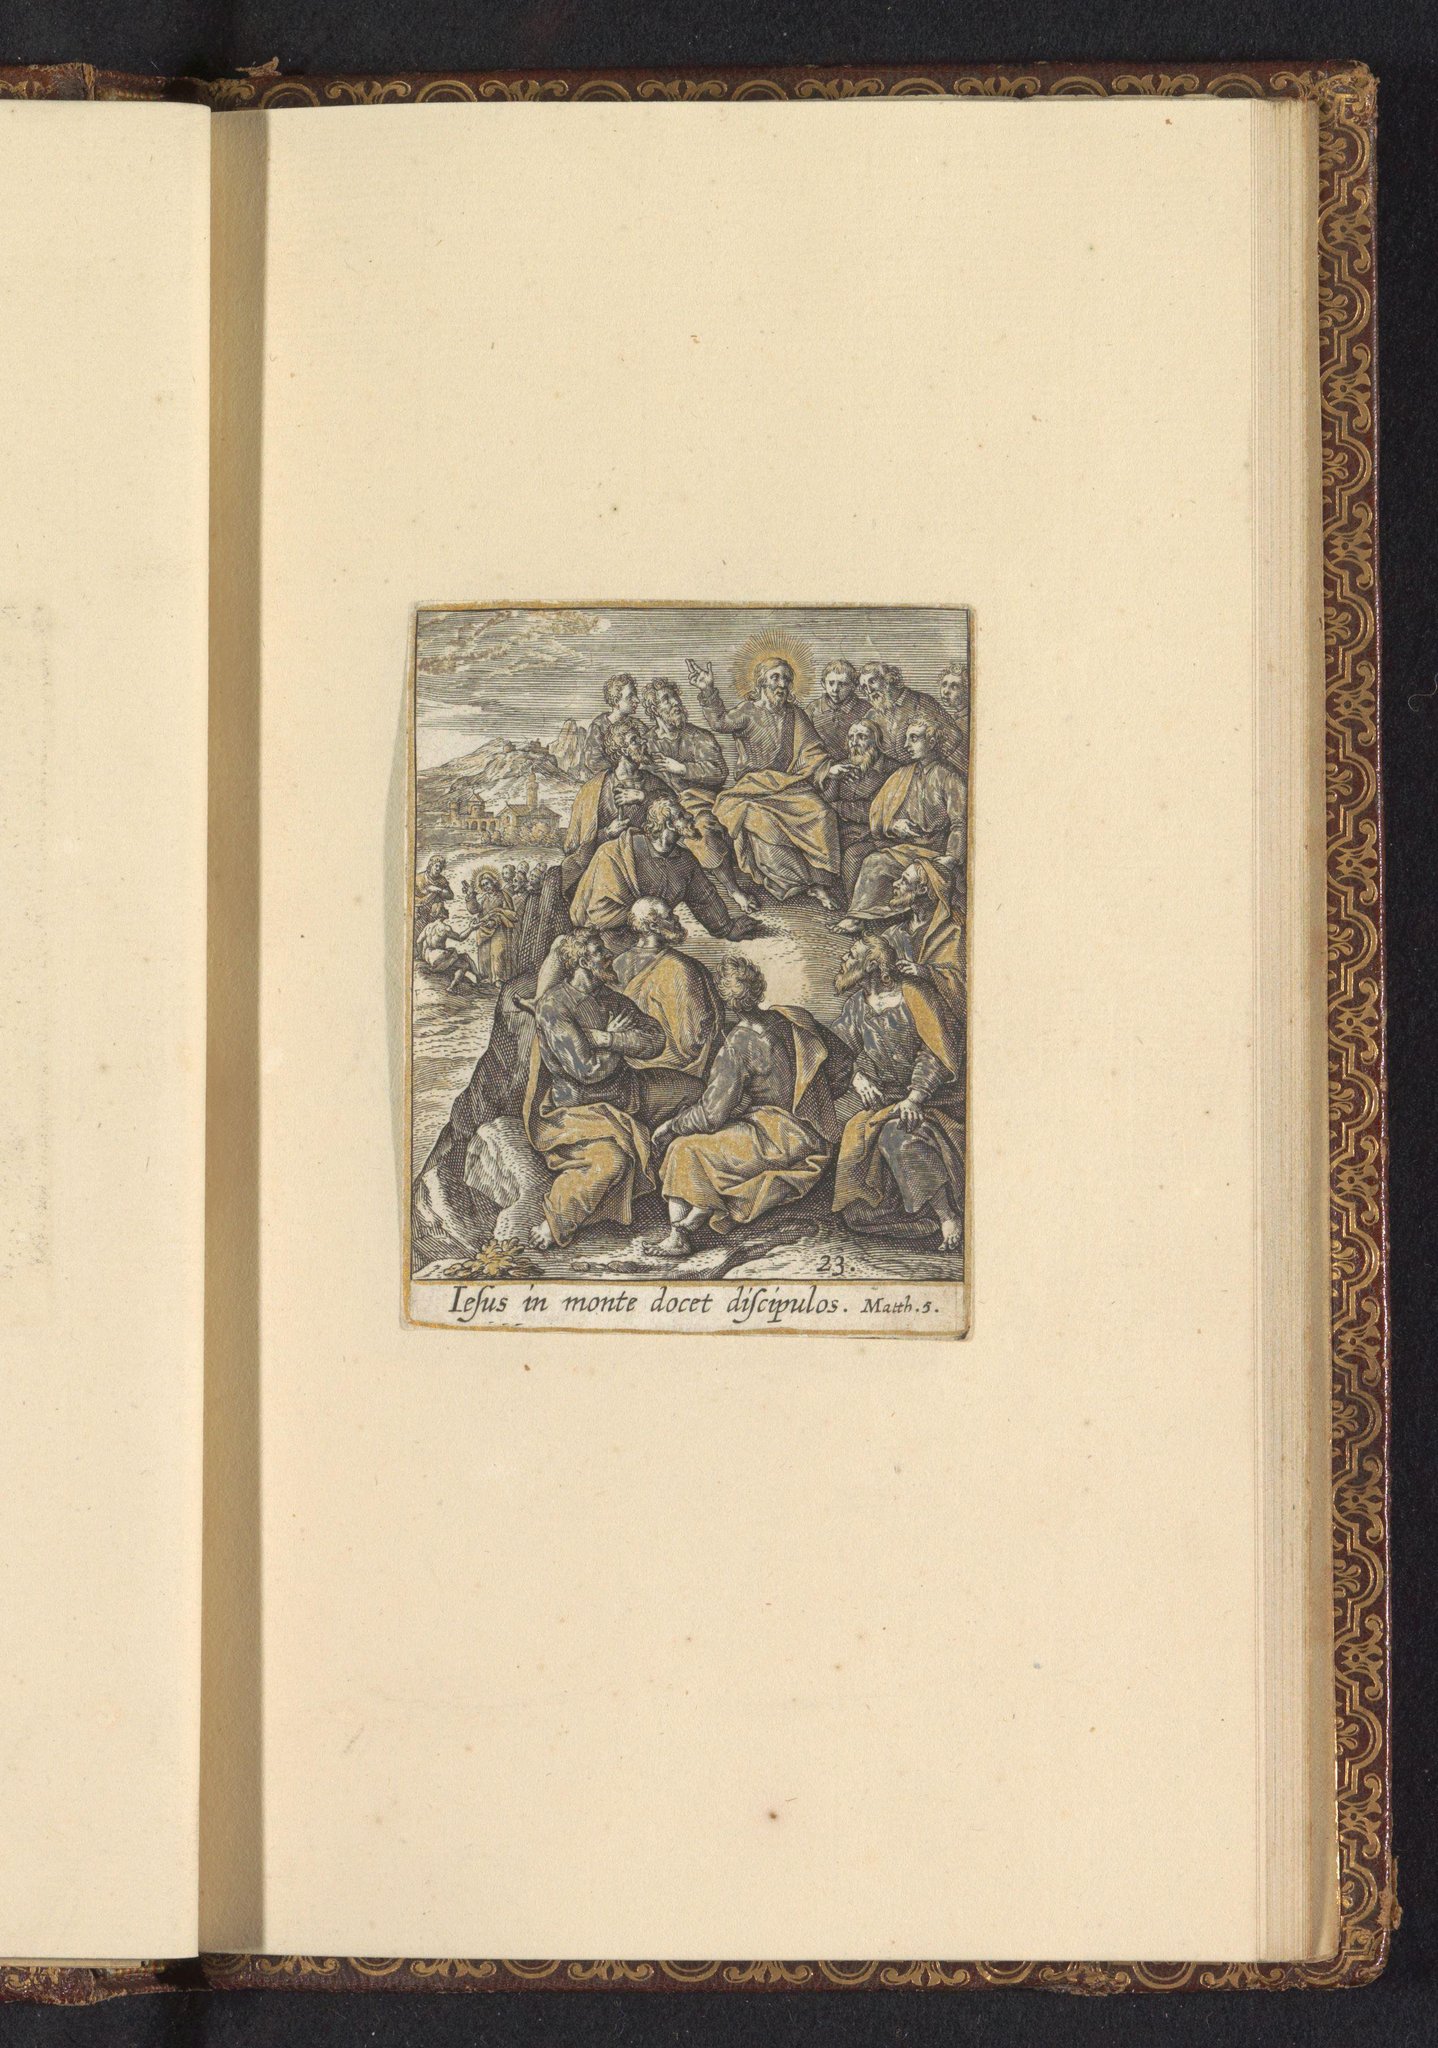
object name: print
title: Bergrede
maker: adriaen collaert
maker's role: draughtsman, print maker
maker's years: 1560-1618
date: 1580-1590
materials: gold, paper, silver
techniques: engraving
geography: antwerp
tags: beatitudes of the sermon on the mount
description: De gravures van beide reeksen zijn door dezelfde hand gehoogd met goud en zilver. De eerste reeks van 34 (van 35) gravures is een verkleinde versie naar prenten uit een reeks naar Maarten de Vos (nrs. 2-28, 31-33) met toevoeging van drie scènes uit de Wonderen van Christus (nrs. 26, 28, 30).